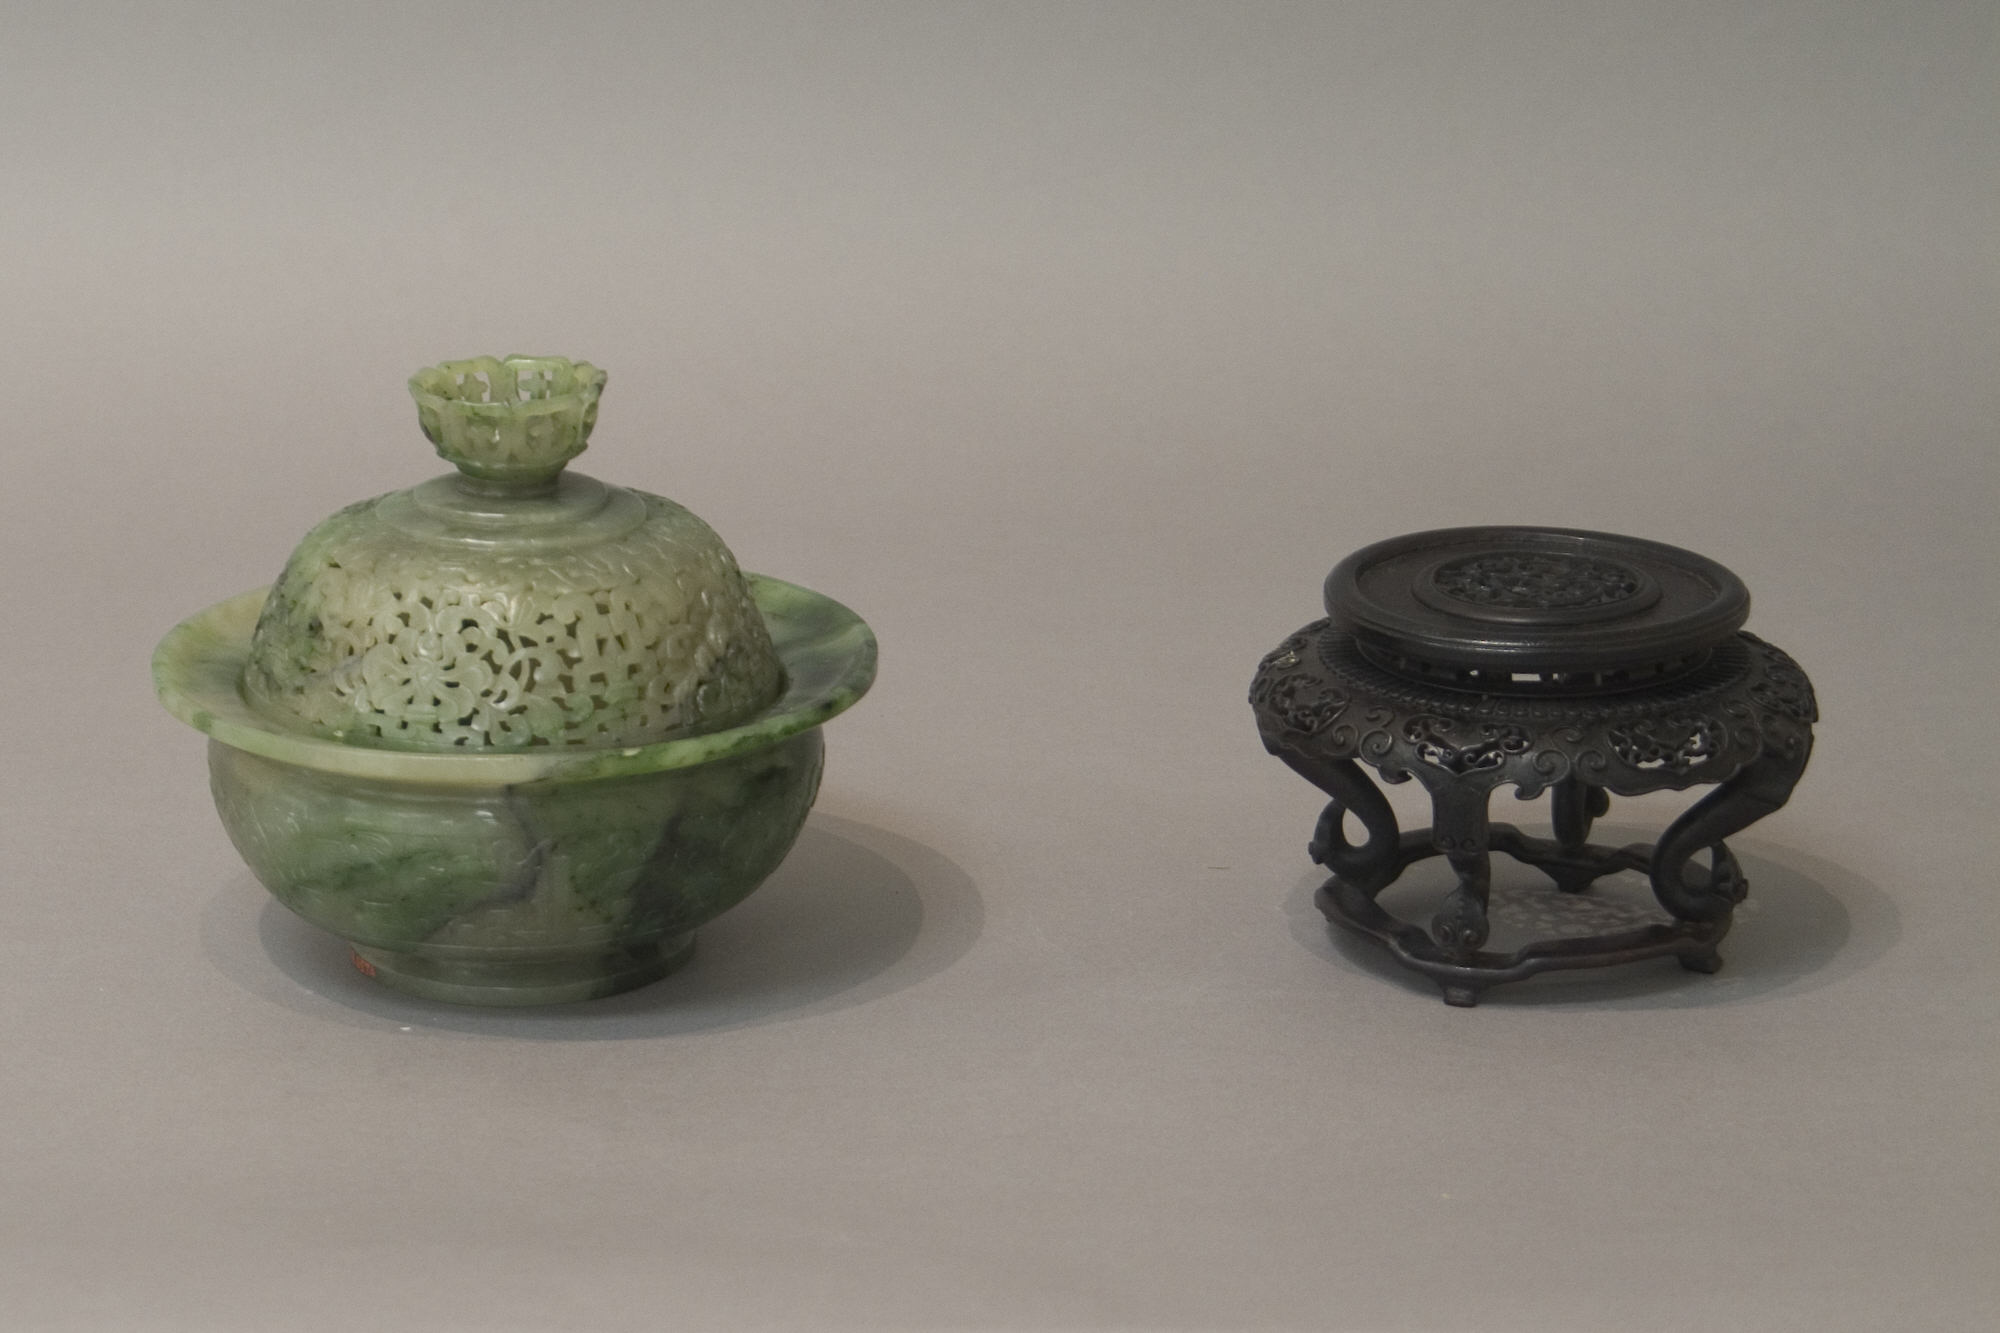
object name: incense burner with cover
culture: chinese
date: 1736-1795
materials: jade